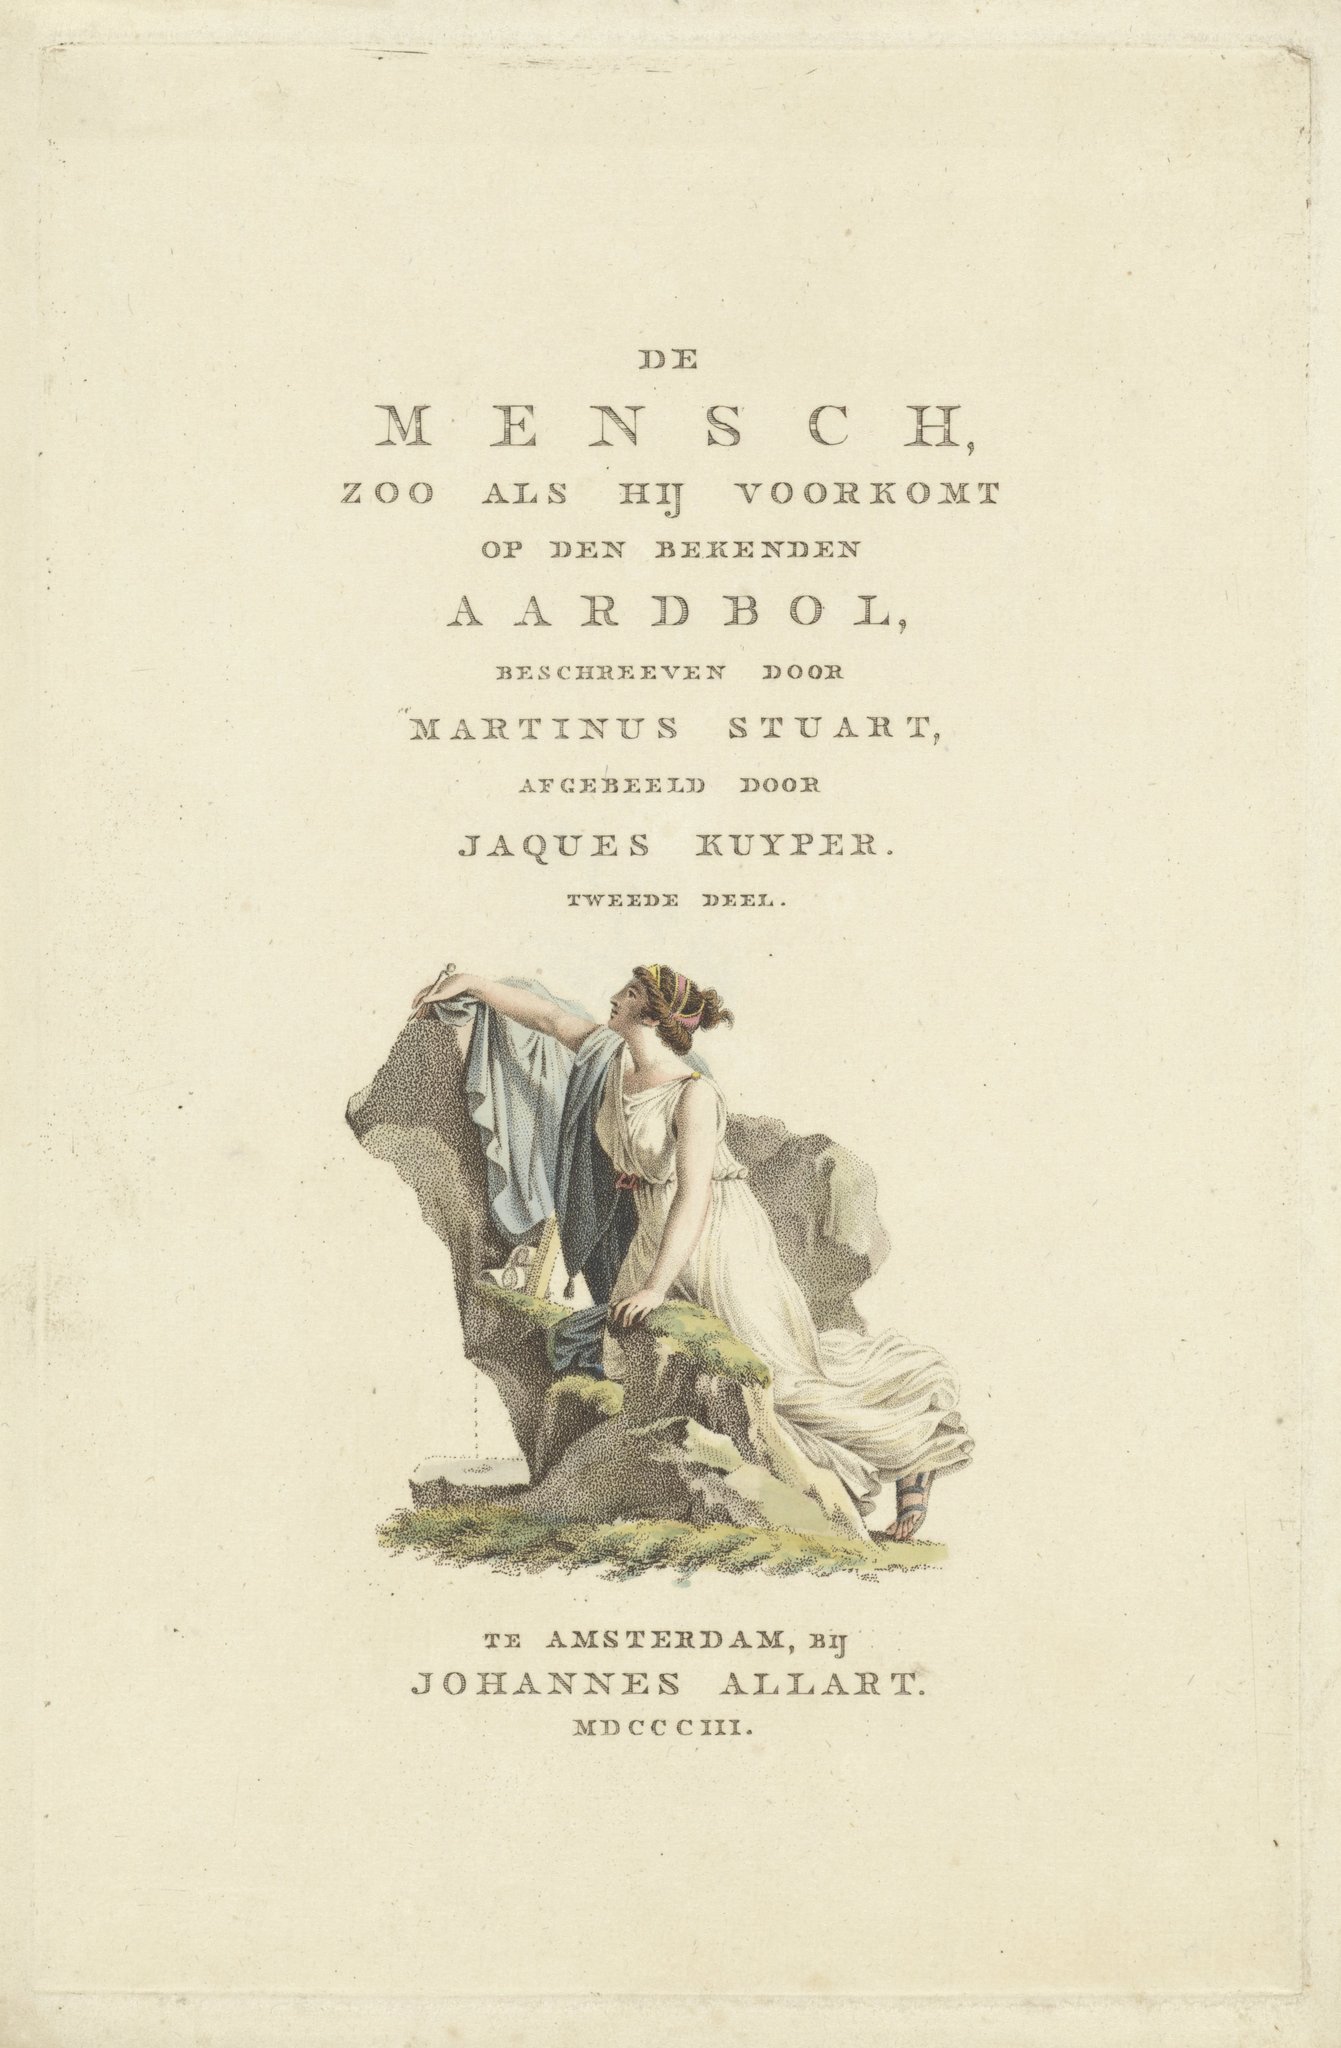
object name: print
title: Titelpagina voor: M. Stuart, De mensch, zoo als hij voorkomt op den bekenden aardbol, 1803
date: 1803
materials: paper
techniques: hand coloring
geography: amsterdam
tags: kneeling figure - aa - female human figure (+ three-quarter view), drawing, measuring, calculating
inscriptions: collector's mark: Lugt 2228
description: Titelpagina voor: Stuart, Martinus. De mensch, zoo als hij voorkomt op den bekenden aardbol, deel II. Amsterdam: Johannes Allart, 1803.